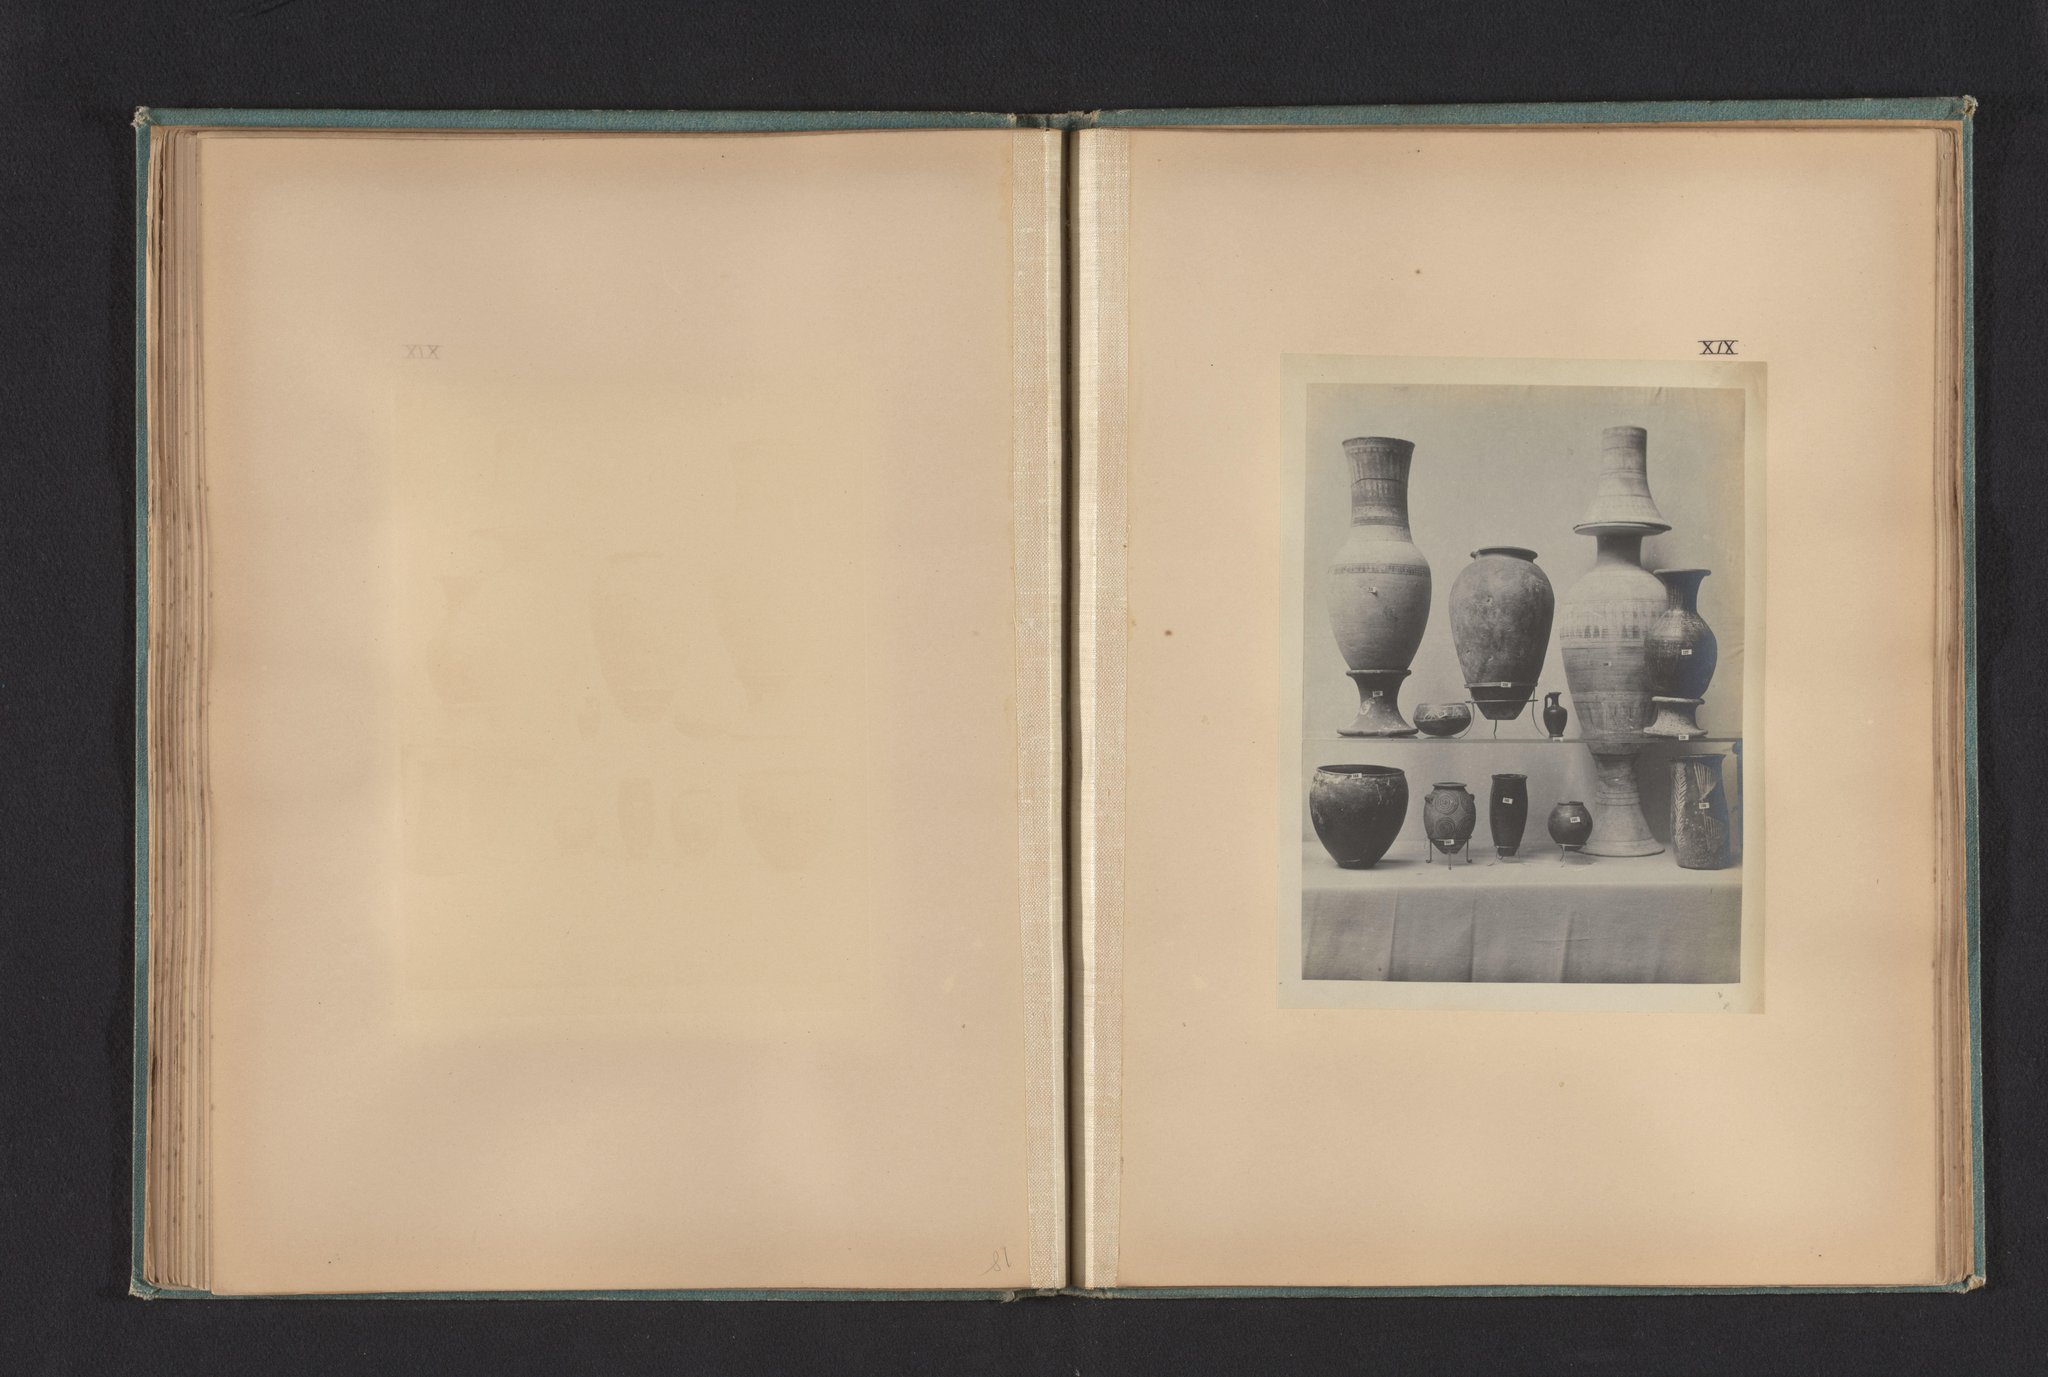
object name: page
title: Elf Egyptische vazen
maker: Anonymous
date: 1890-1895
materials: photographic support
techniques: gelatin silver print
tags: containers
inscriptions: number: ‘XIX’